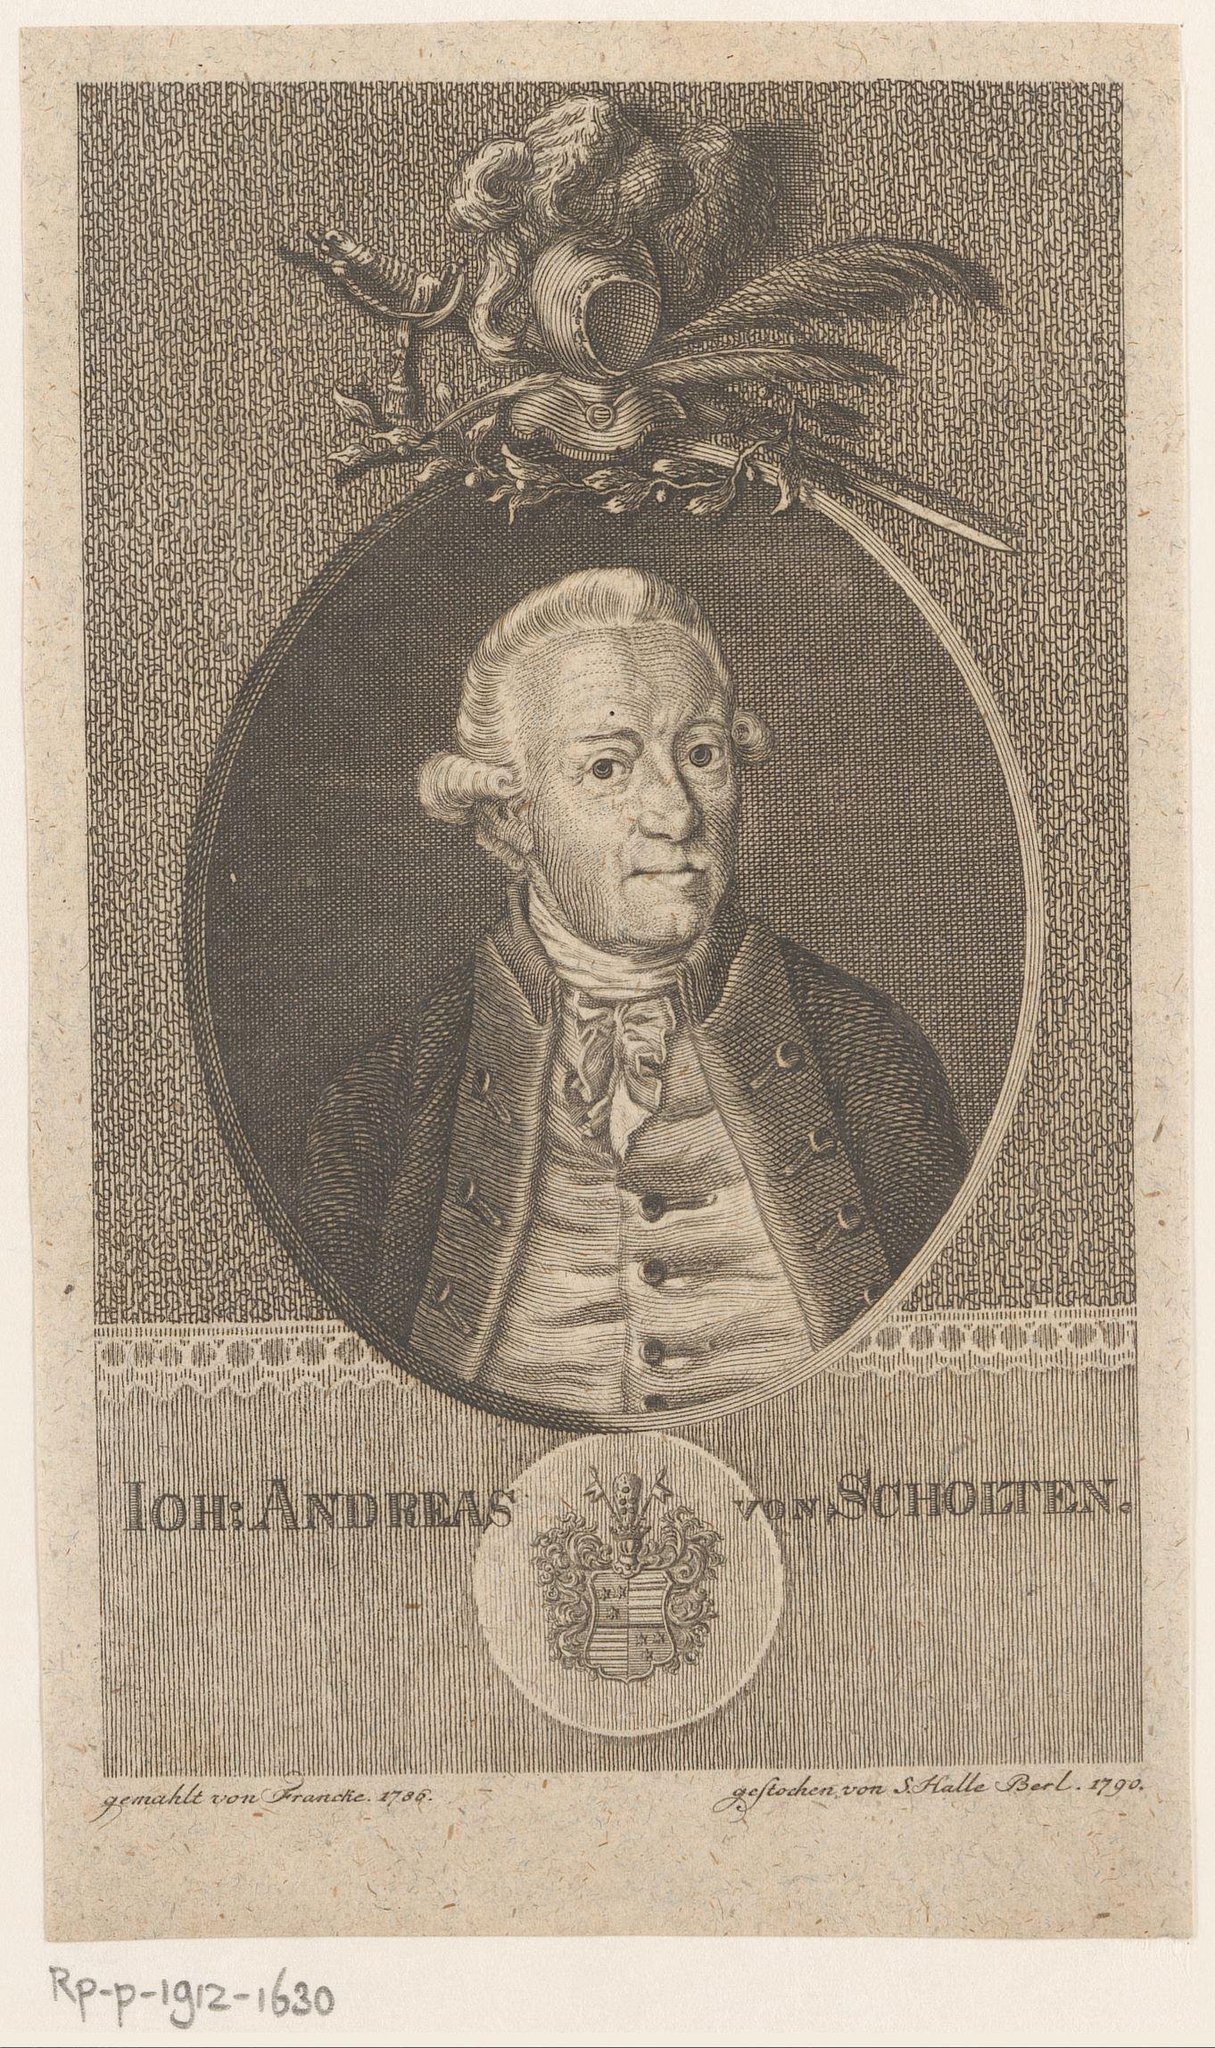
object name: print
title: Portret van Johann Anton Andreas von Scholten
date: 1786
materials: paper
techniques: engraving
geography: berlin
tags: historical persons, symbols, allegories of war; 'guerra' (ripa), armorial bearing, heraldry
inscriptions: collector's mark: Lugt 2228